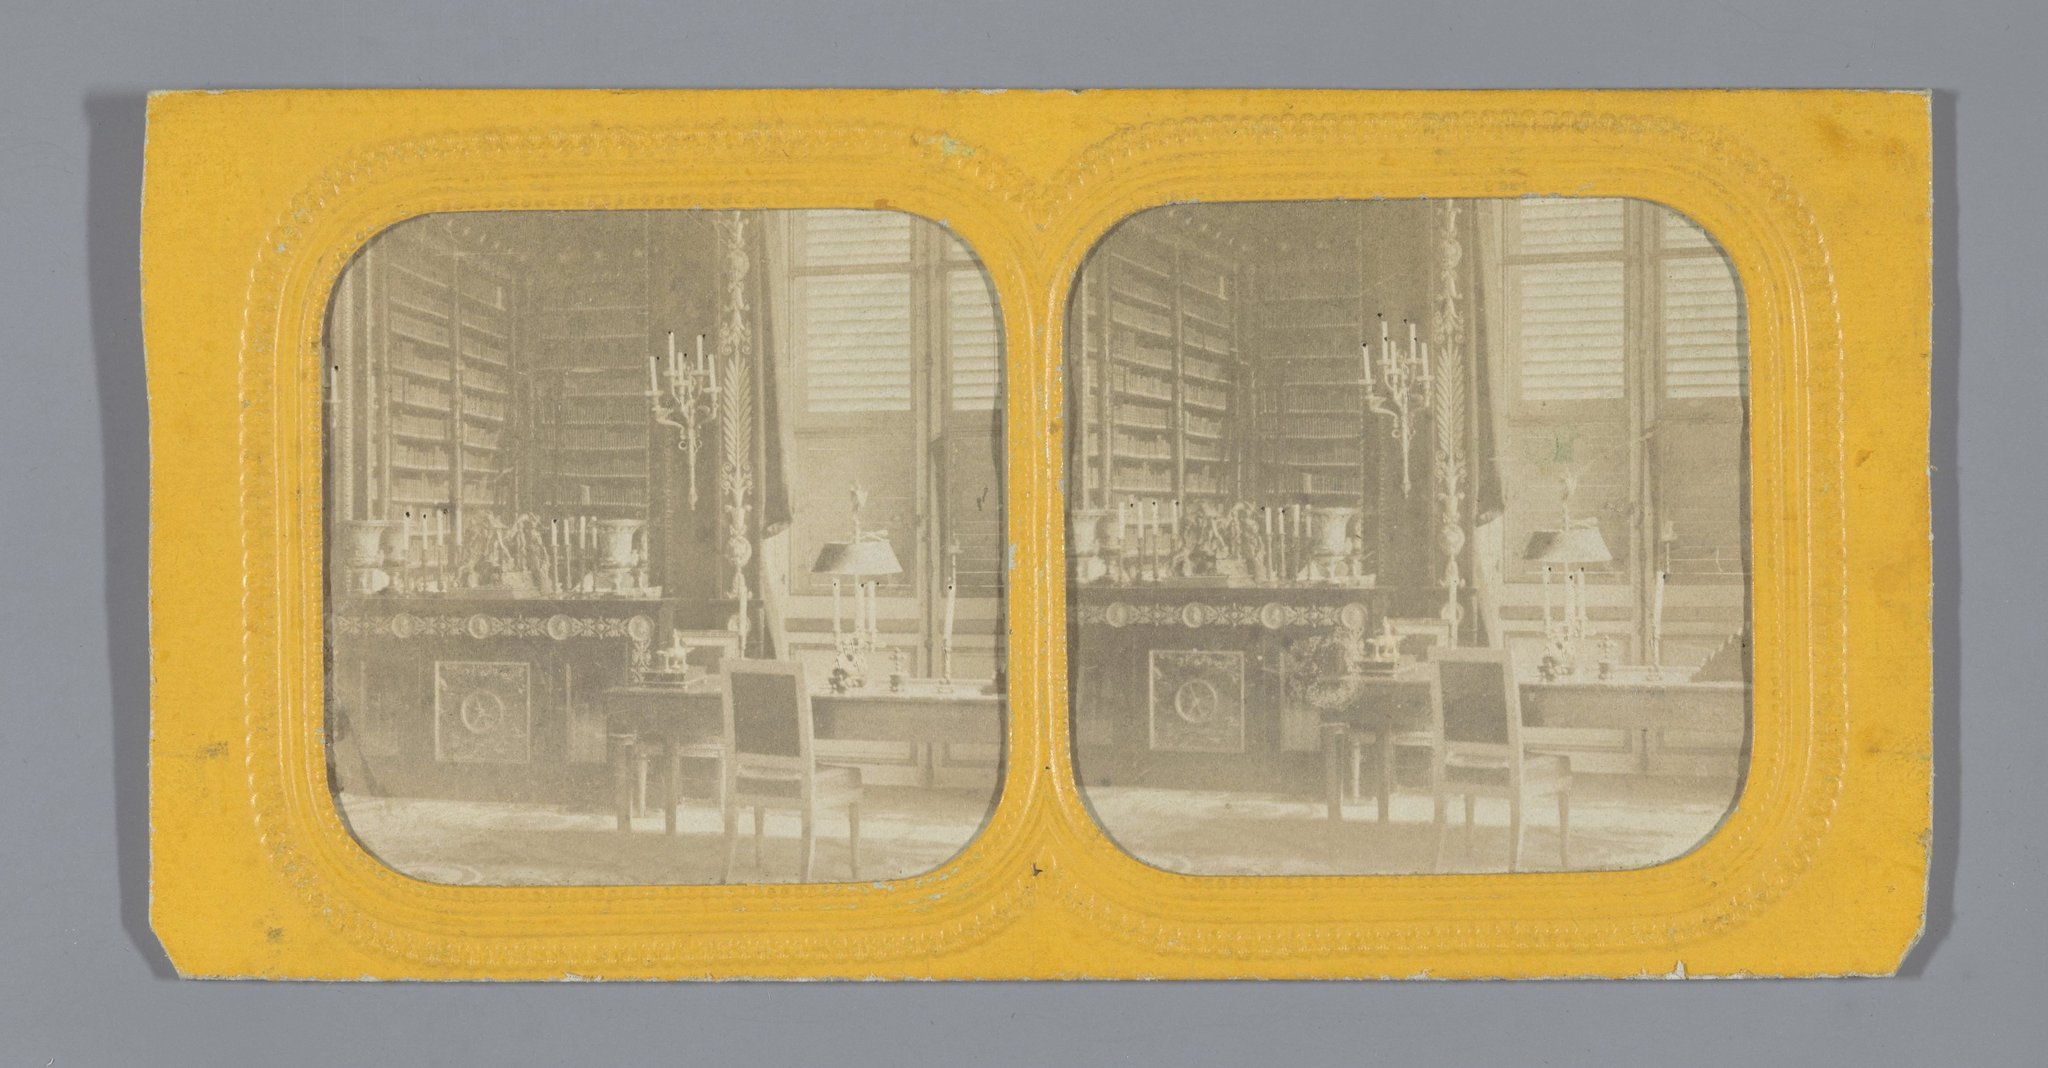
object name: tissue stereograph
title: Bibliothèque de l'Empereur à Compiègne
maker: Anonymous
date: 1855-1875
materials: cardboard, paper, photographic support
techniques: albumen print, hand coloring, perforating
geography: compiègne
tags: study; 'studiolo'; library, interior ~ representation of a building